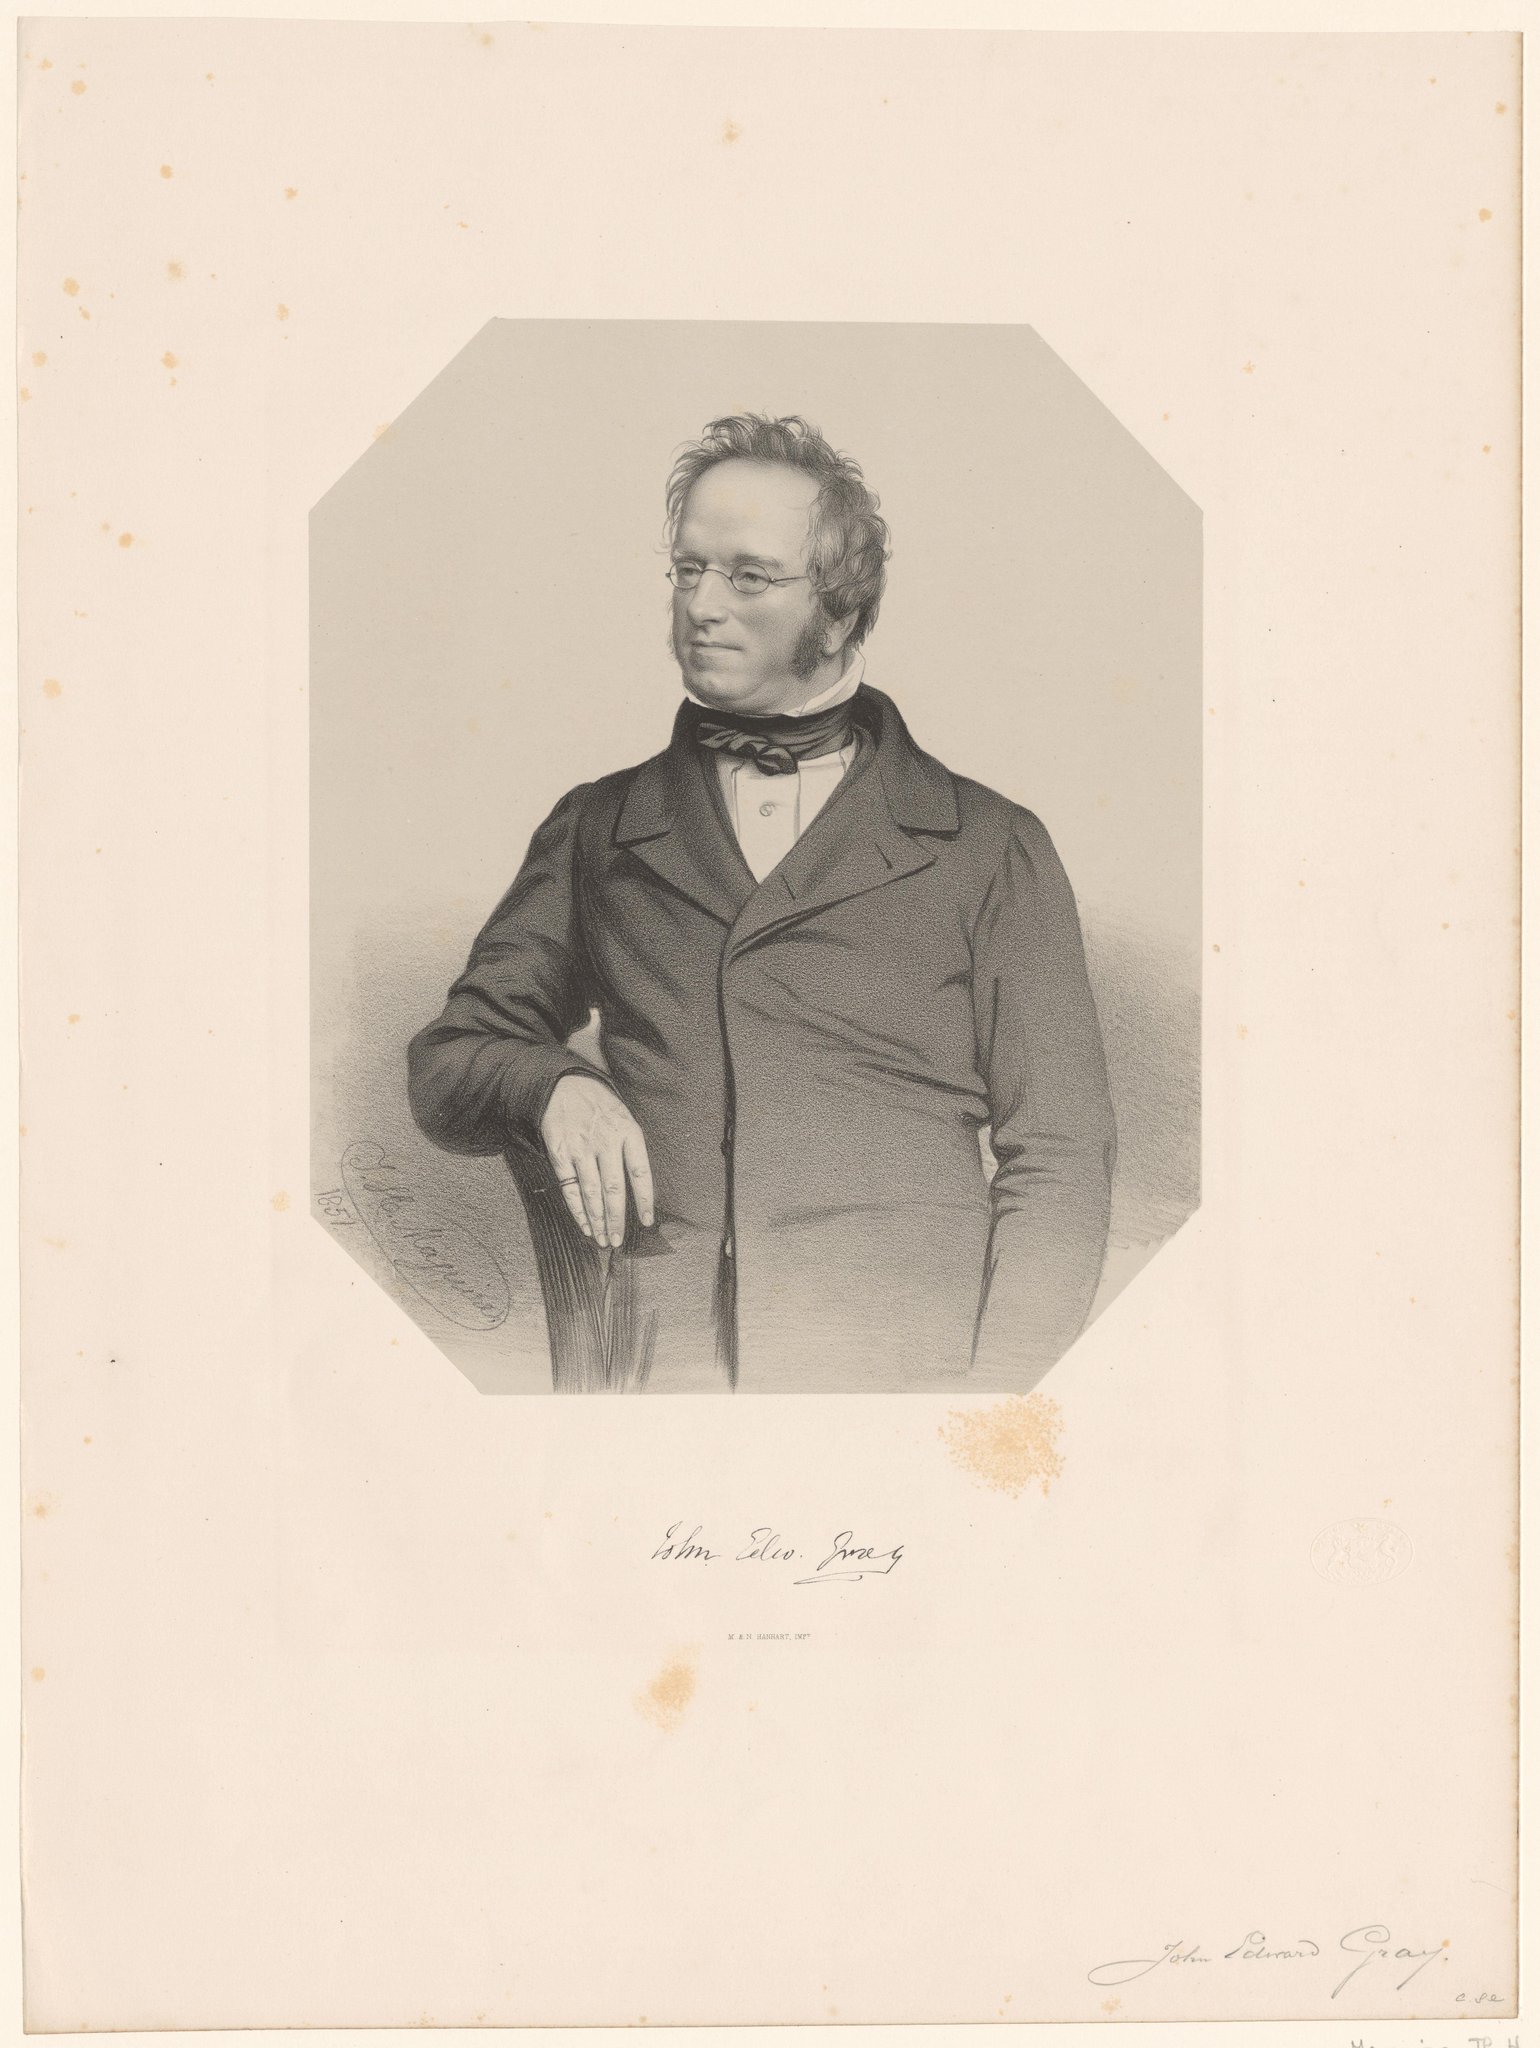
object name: print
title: Portretten uit het Ipswich Museum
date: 1852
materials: paper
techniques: lithograph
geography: london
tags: adult man, historical persons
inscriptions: collector's mark: Lugt 2228, check stamp: ‘Ipswich Museum’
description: Prent behoort tot de serie 'Ipswich Museum Portraits', ook bekend onder de titel 'Portraits of Honorary Members of the Ipswich Museum'. Deze serie is in 1852 door George Ransome uitgegeven en gedrukt door M&N Hanhart tussen 1848 en 1852. De serie bestaat uit ca. 60 portretten.